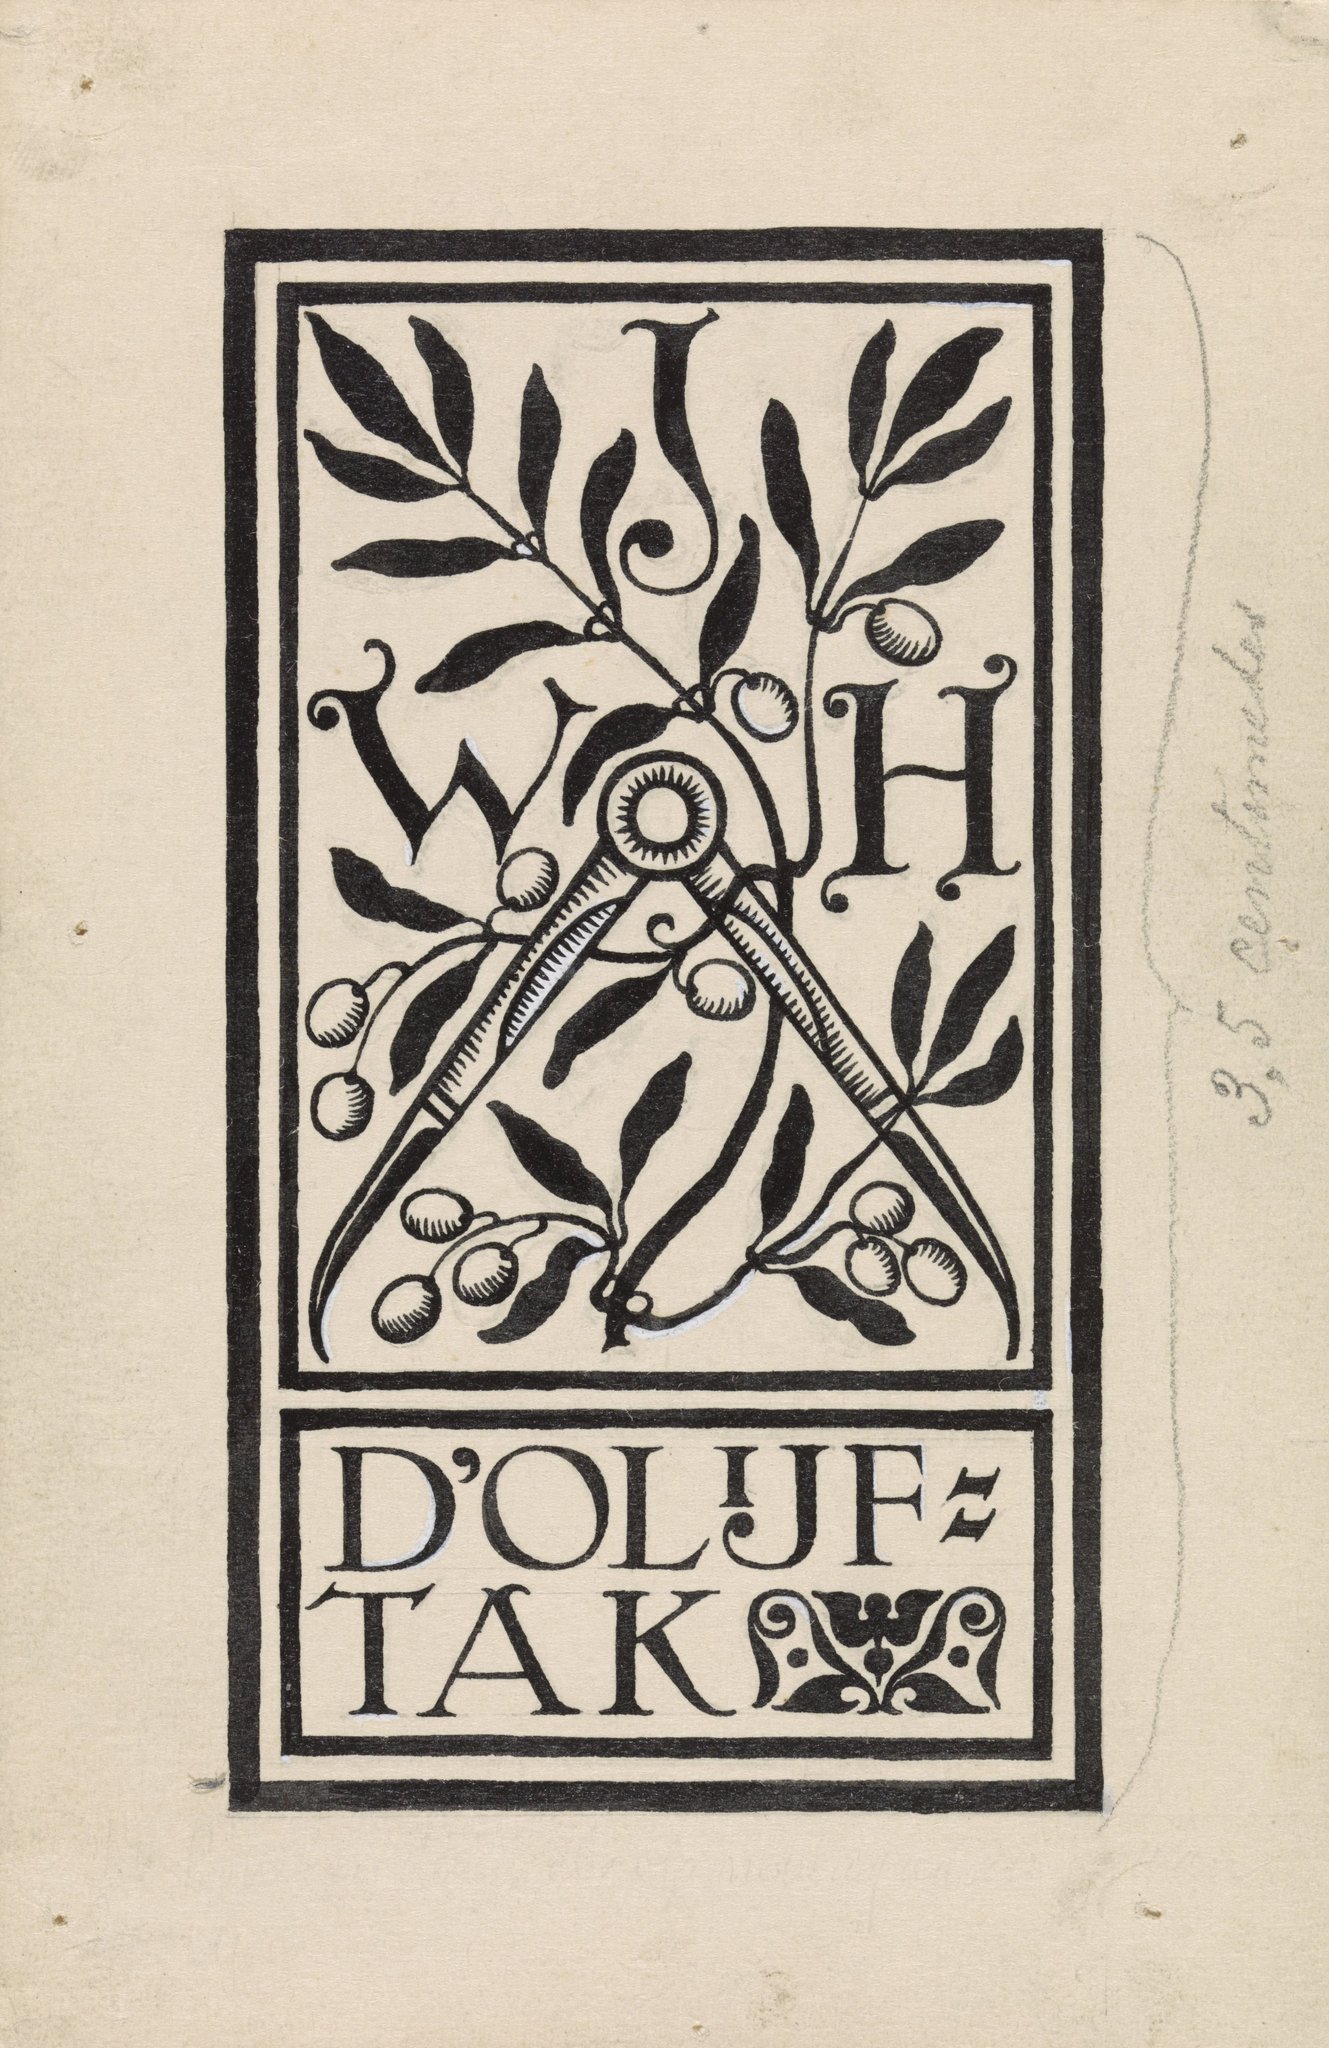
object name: drawing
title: D'Olijftak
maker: antoon derkinderen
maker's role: draughtsman, painter, print maker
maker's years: 1859-1925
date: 1869-1925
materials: paint, paper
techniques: brush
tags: compasses, trees: olive-tree (+ branch, stick)